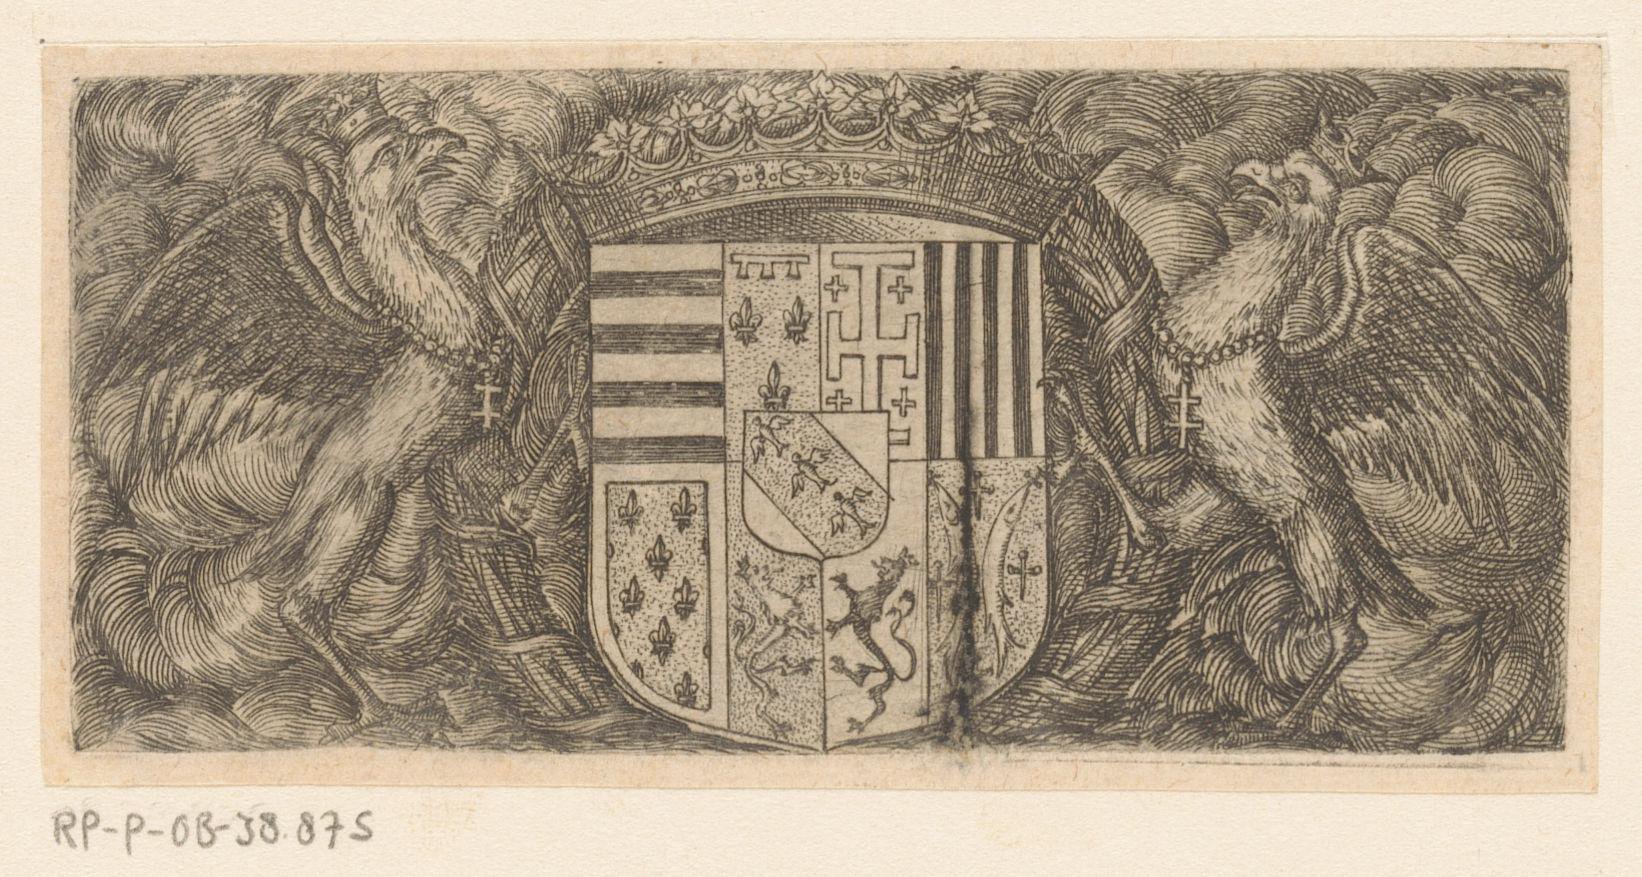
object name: print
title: Wapenschild van het hertogdom Lotharingen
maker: Anonymous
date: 1600-1699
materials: paper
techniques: etching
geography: italy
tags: predatory birds: eagle, specific forms of the cross: lorraine cross, armorial bearing, heraldry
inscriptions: collector's mark: Lugt 2228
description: Het wapenschild wordt geflankeerd door twee adelaars.